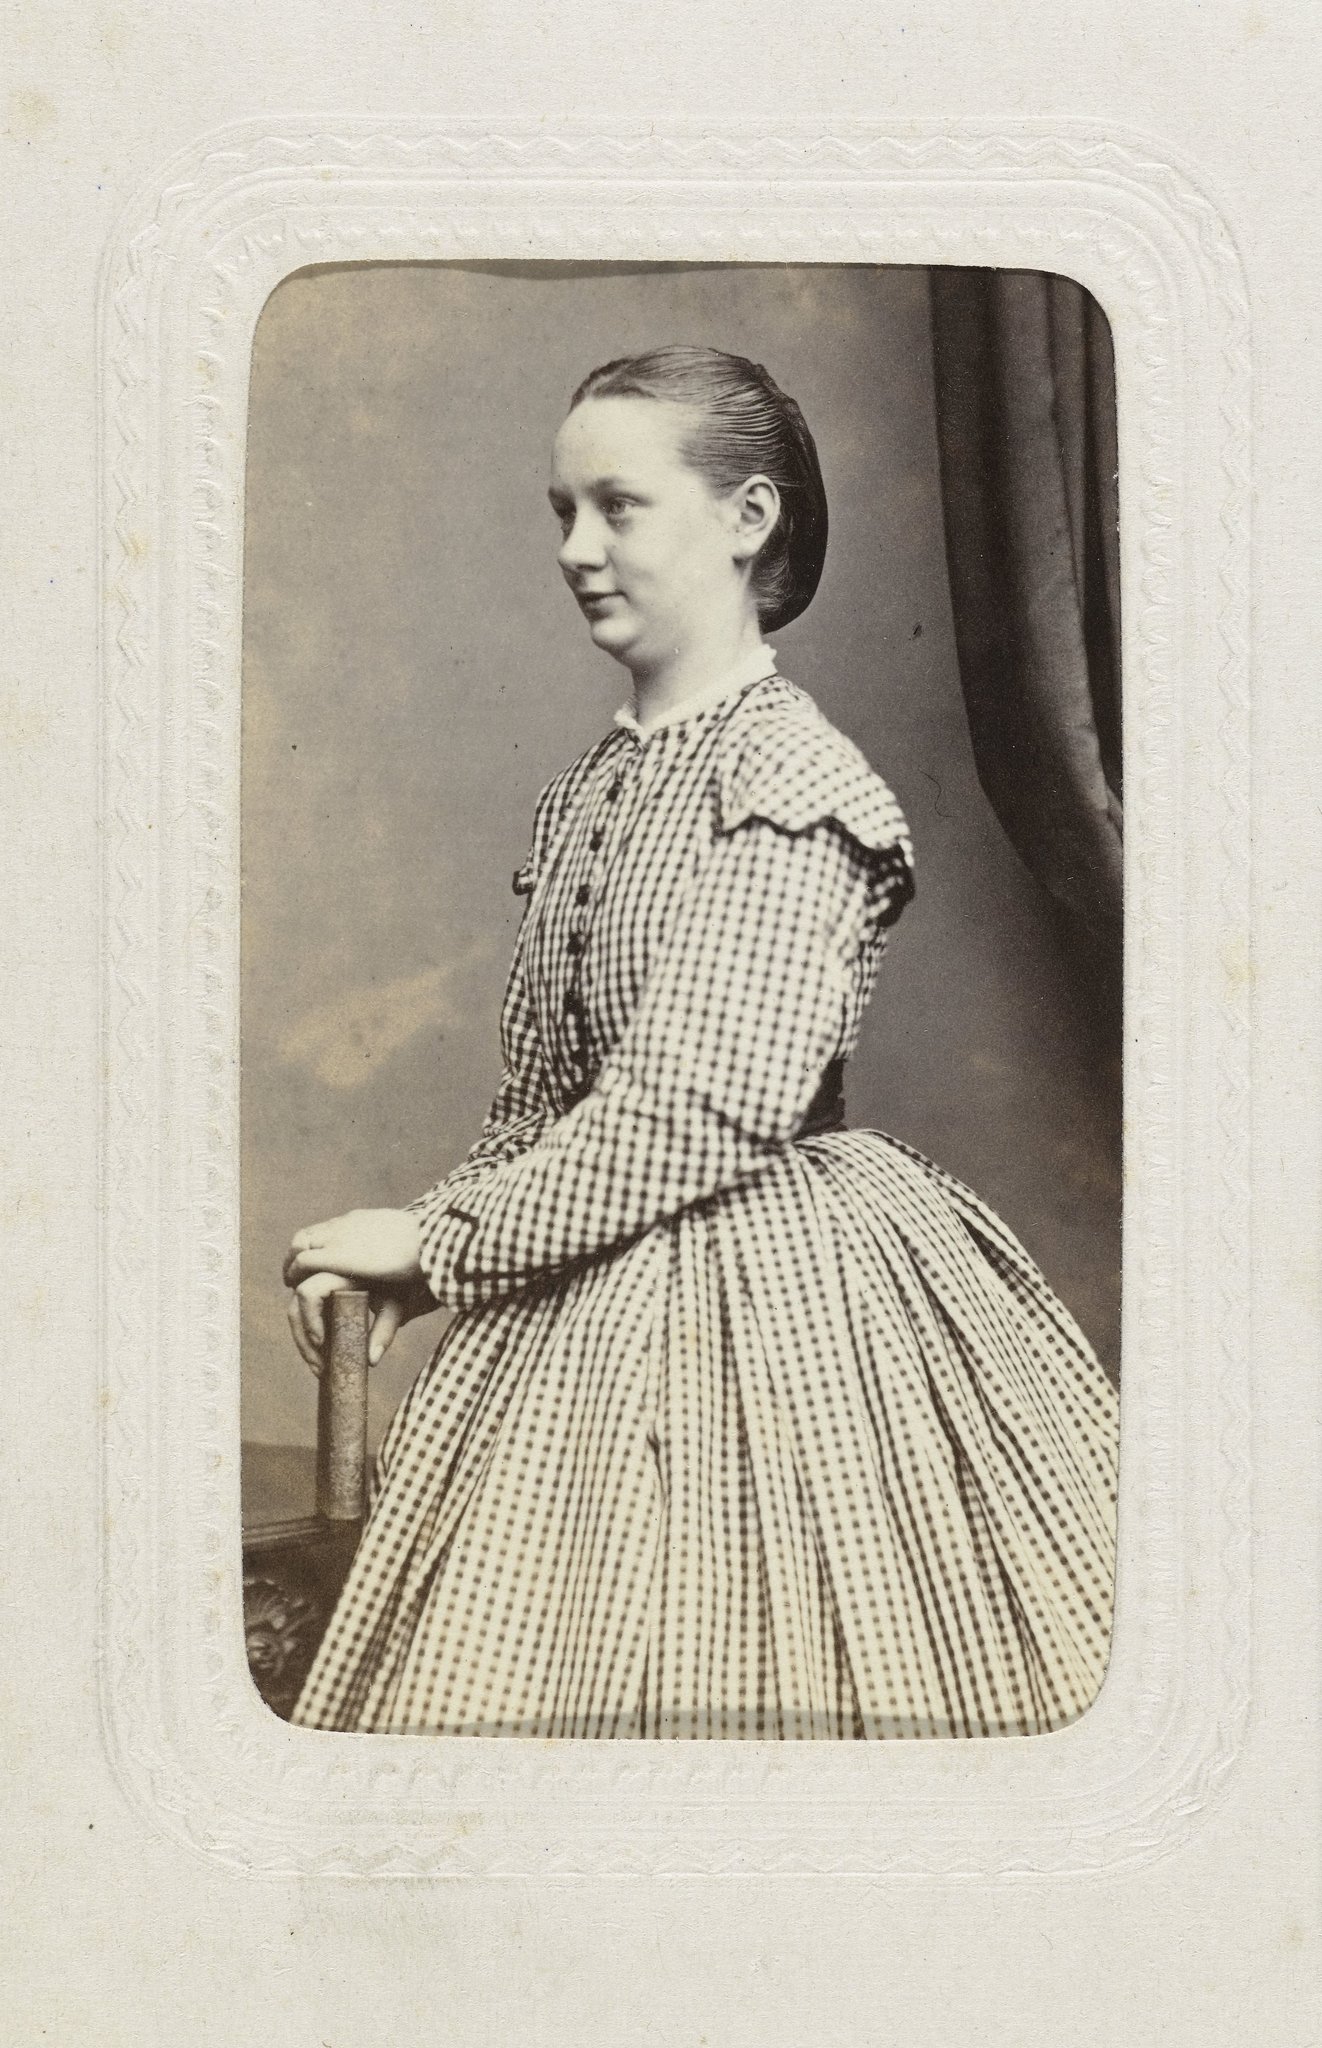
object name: carte de visite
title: Studioportret van een vrouw in ruitjesjurk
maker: Anonymous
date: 1863-1870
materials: cardboard, paper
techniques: albumen print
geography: amsterdam